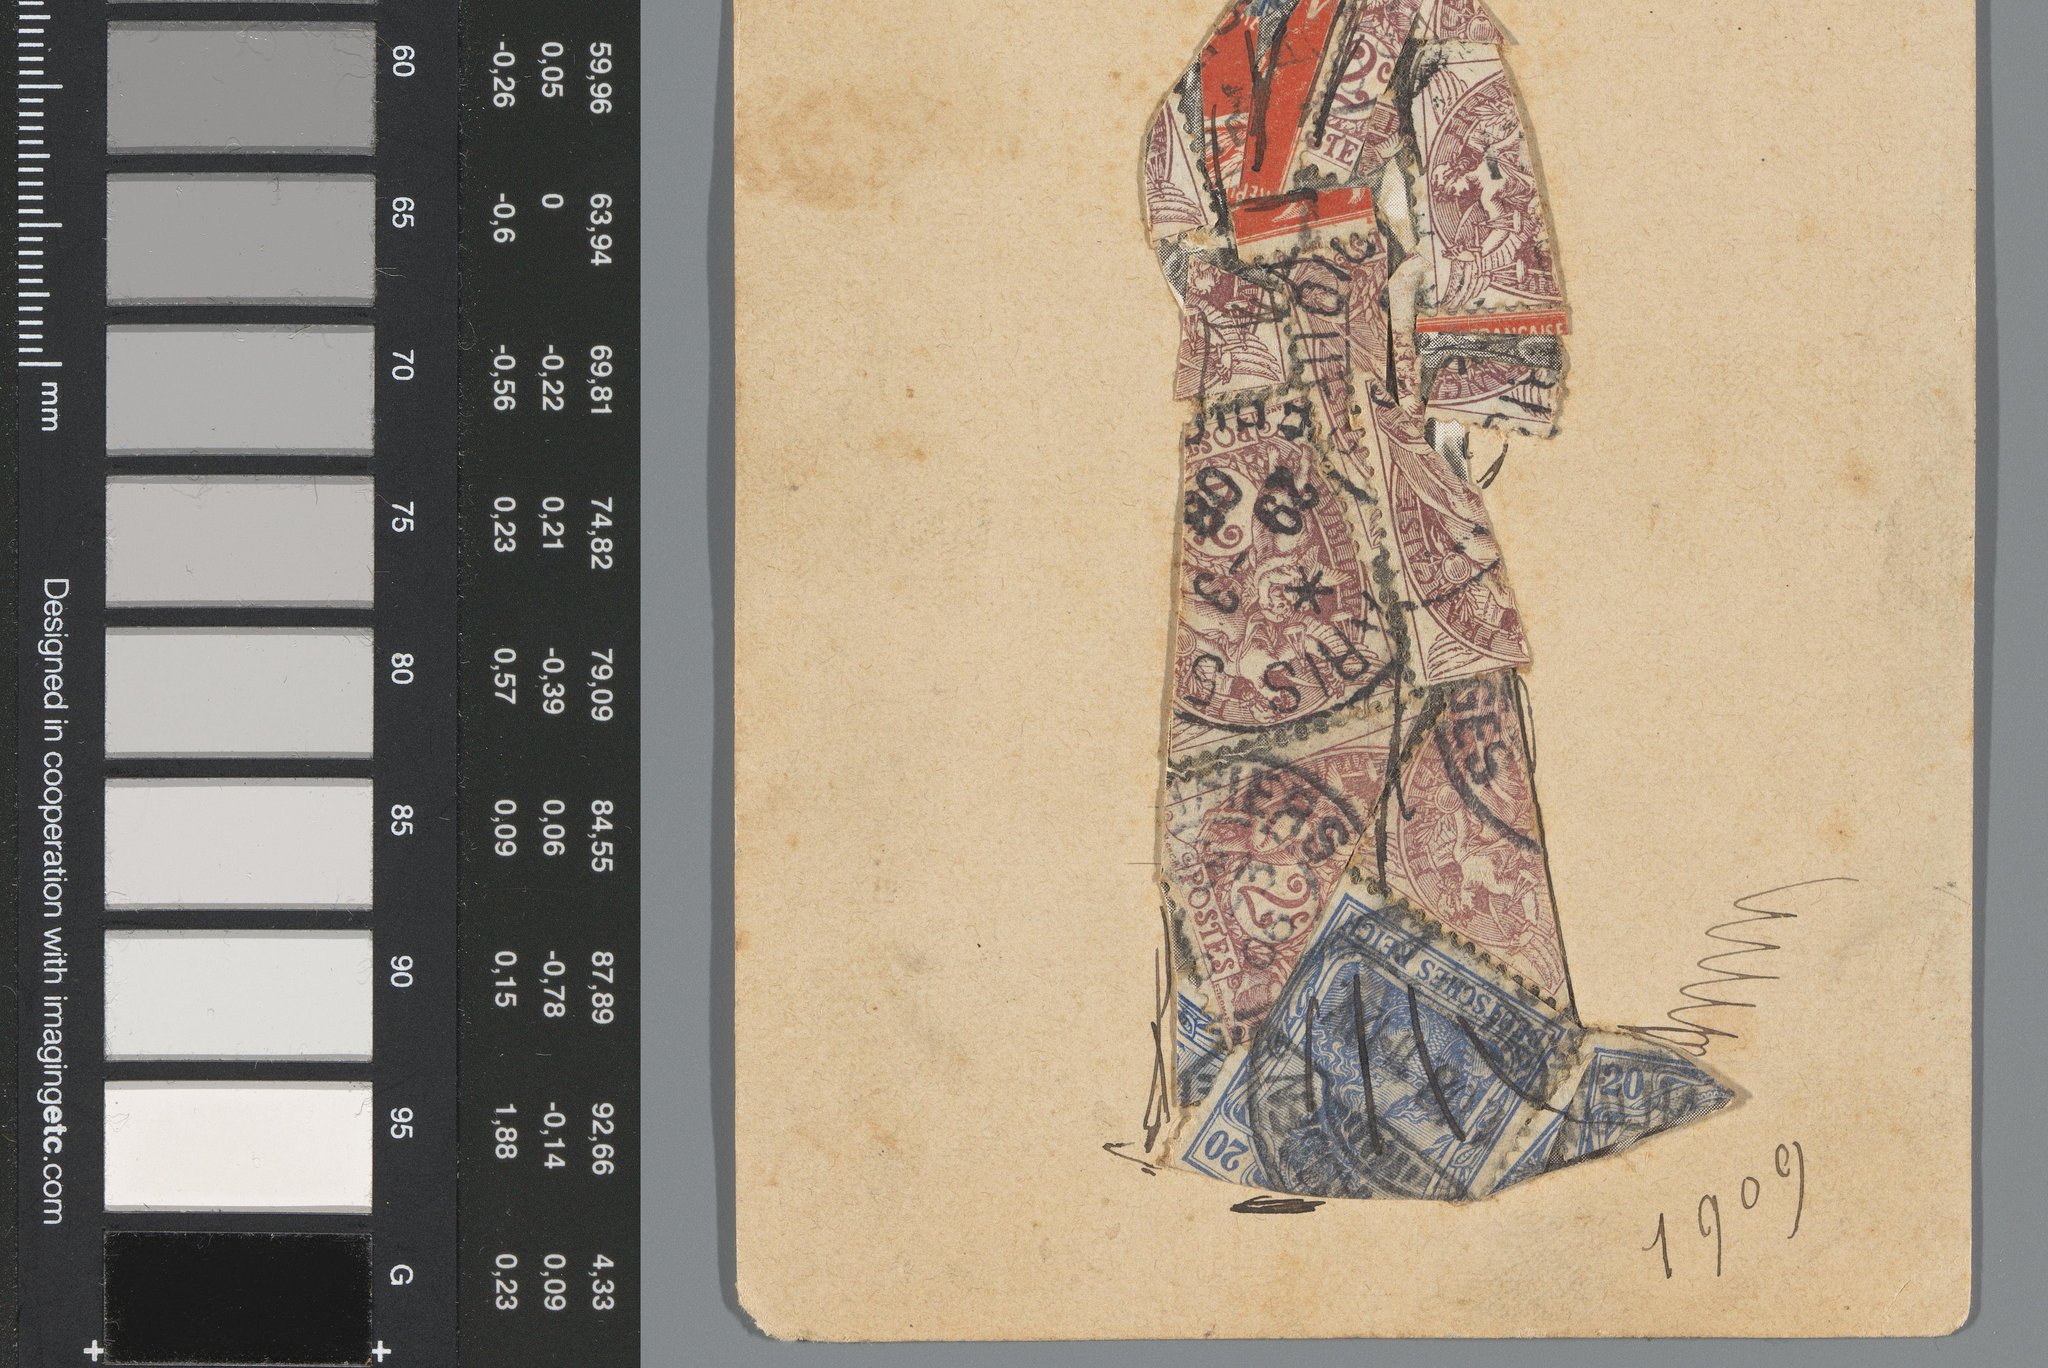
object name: ansichtkaart, prentbriefkaart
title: Portret van een vrouw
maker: Anonymous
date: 1909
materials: paper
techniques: collage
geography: france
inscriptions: date: ‘1909’, stamp, inscription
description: Portret van een vrouw, waarbij de hoed en de jas of jurk zijn opgebouwd uit gevouwen (Duitse en Franse) postzegels (over een in autotypie gedrukte foto heen, waarvan het hoofd en de hand en enkele andere details onbedekt en dus zichtbaar zijn)